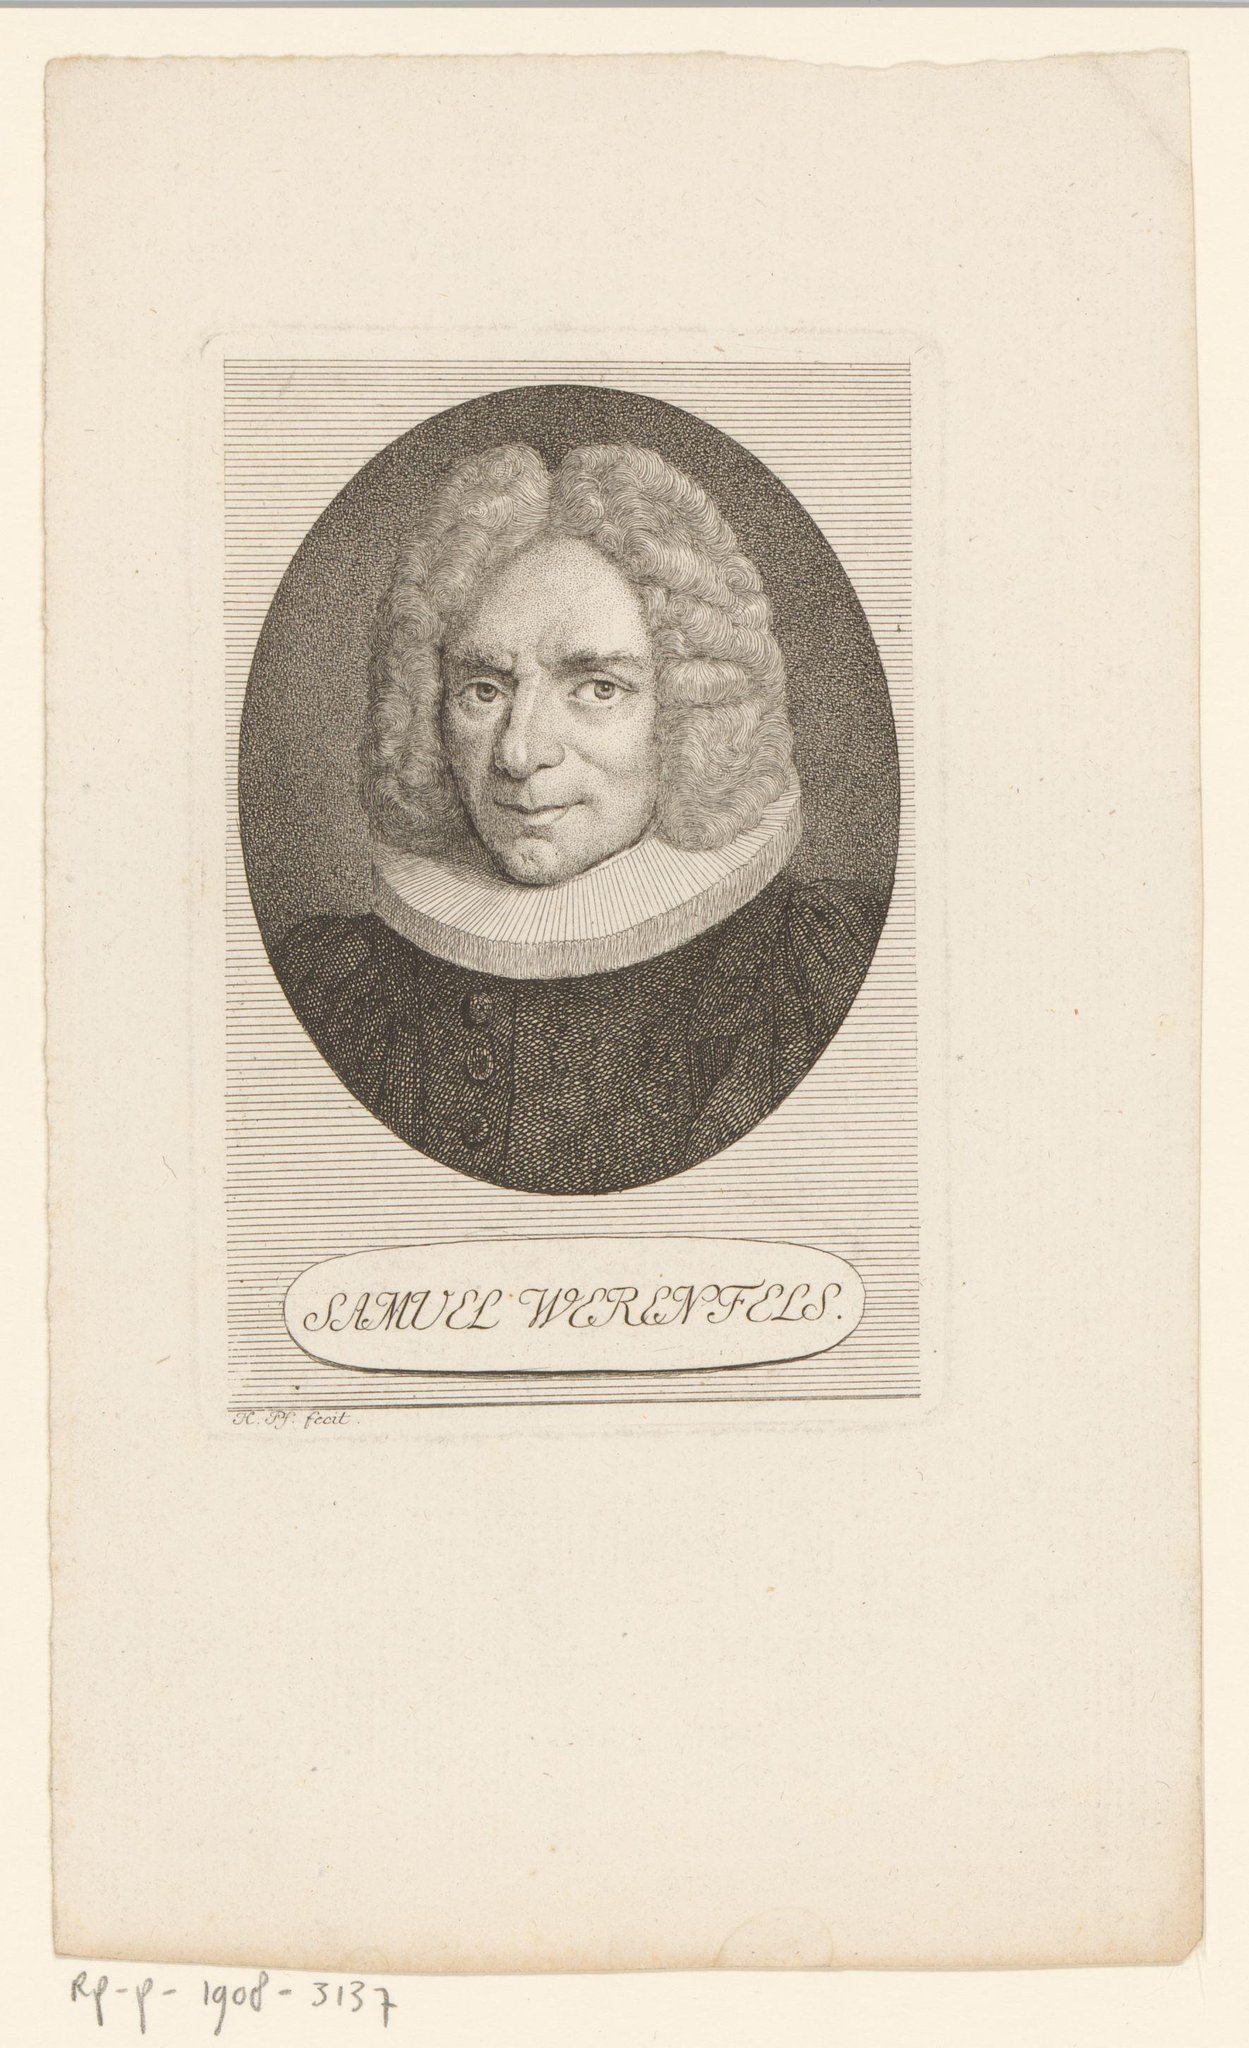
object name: print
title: Portret van Samuel Werenfels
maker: heinrich pfenninger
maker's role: print maker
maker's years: 1749-1815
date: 1759-1815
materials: paper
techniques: etching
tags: historical persons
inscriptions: collector's mark: Lugt 2228